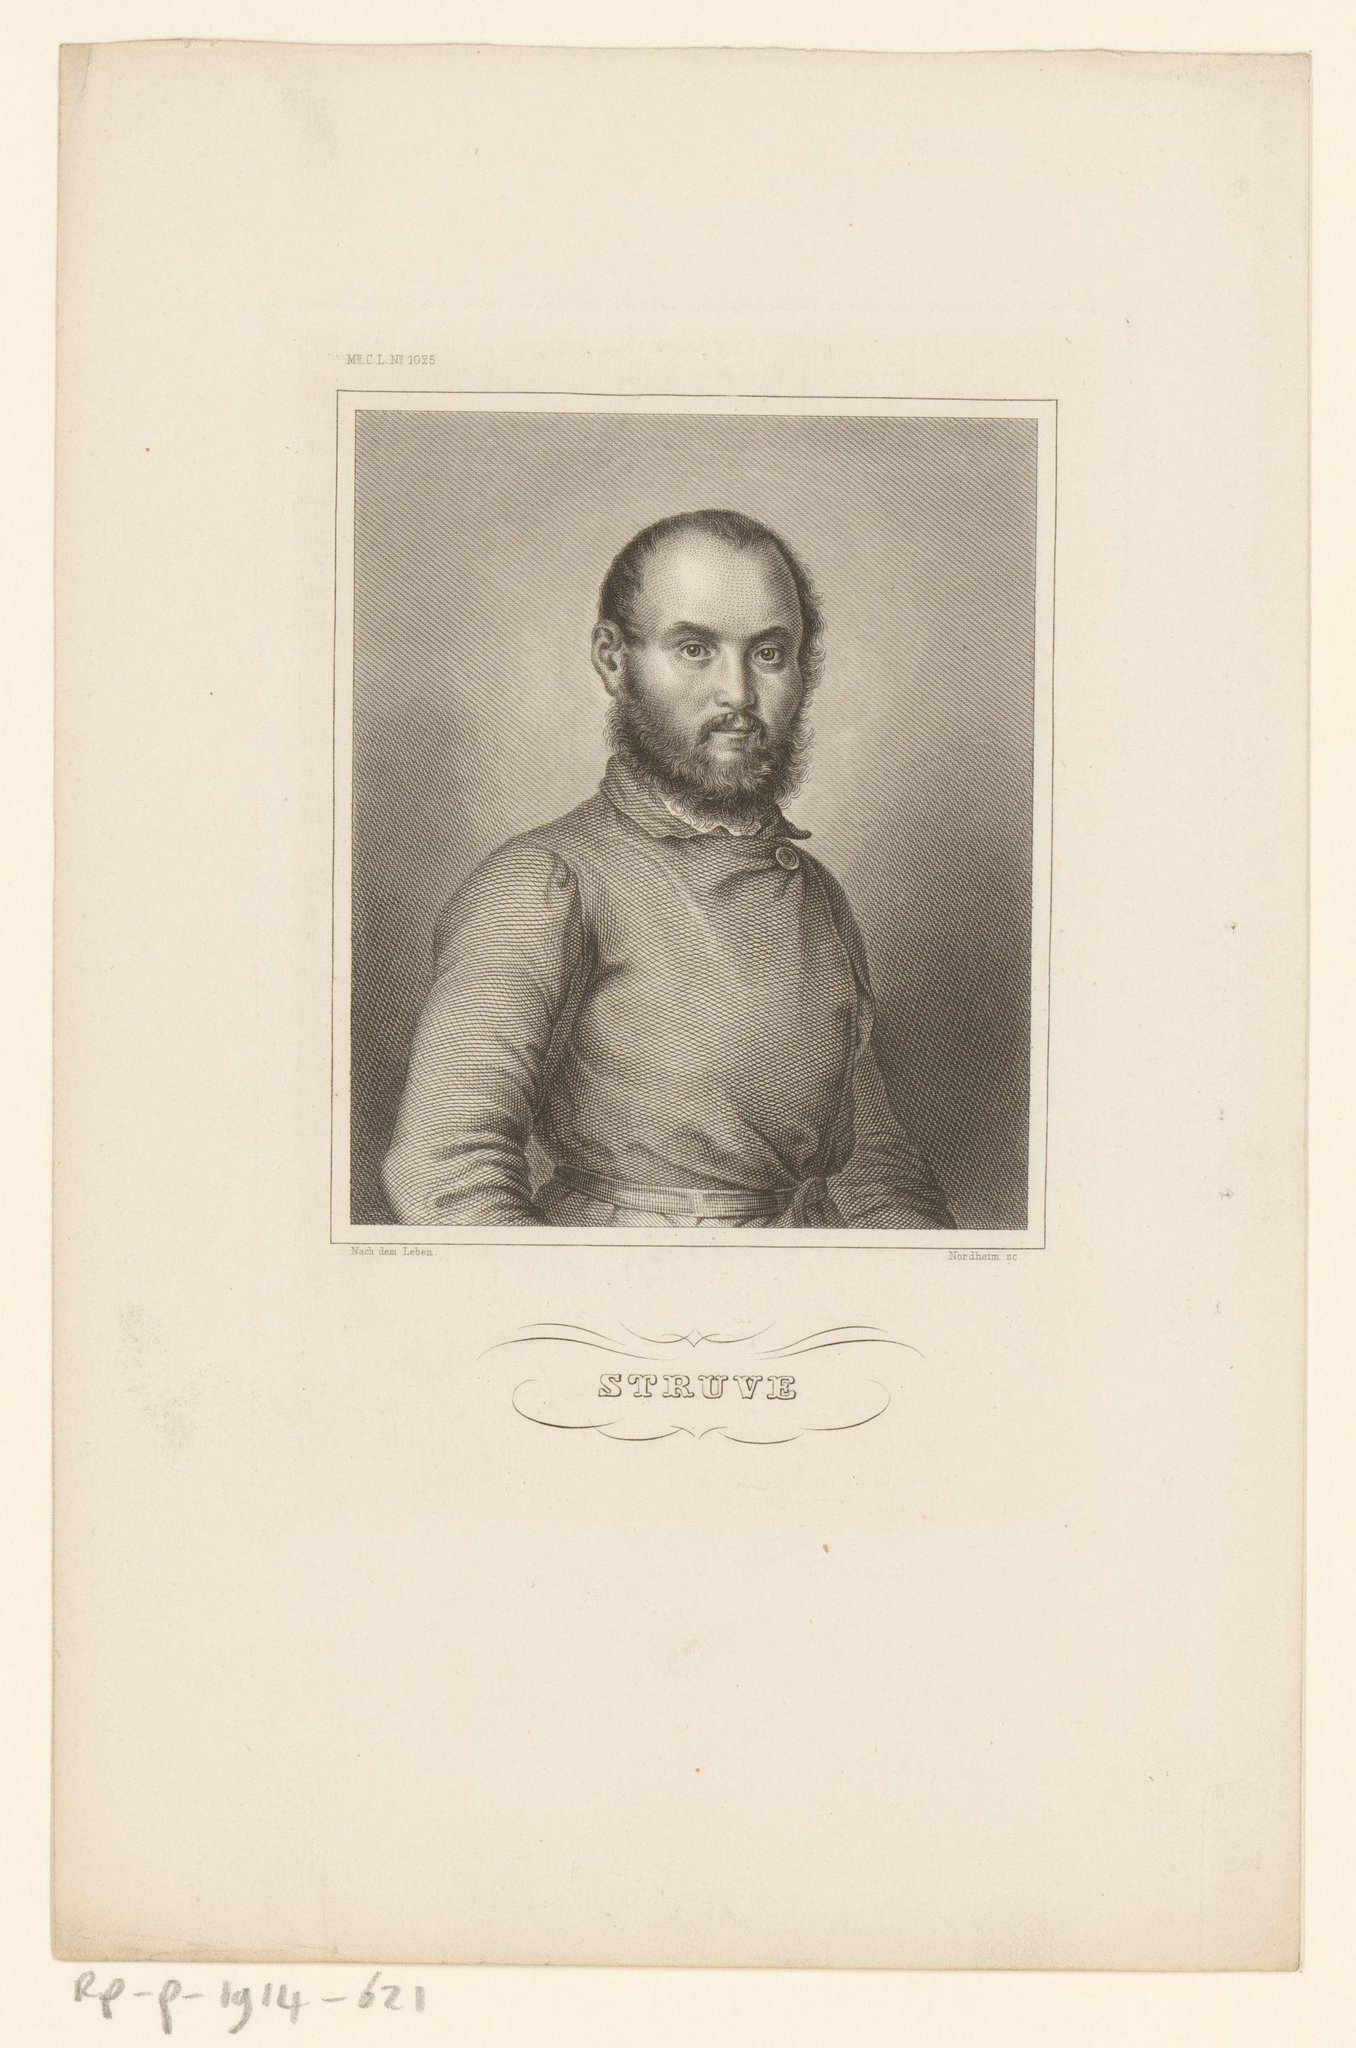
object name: print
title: Portret van Gustav Struve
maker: johann georg nordheim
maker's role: print maker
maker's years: 1804-1853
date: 1840-1855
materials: paper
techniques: engraving, etching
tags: vienna, politician, historical persons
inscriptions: collector's mark: Lugt 2228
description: Prent afkomstig uit: Conversations-Lexikon für die gebildeten Stände, voor het eerst uitgegeven tussen 1840-1855.